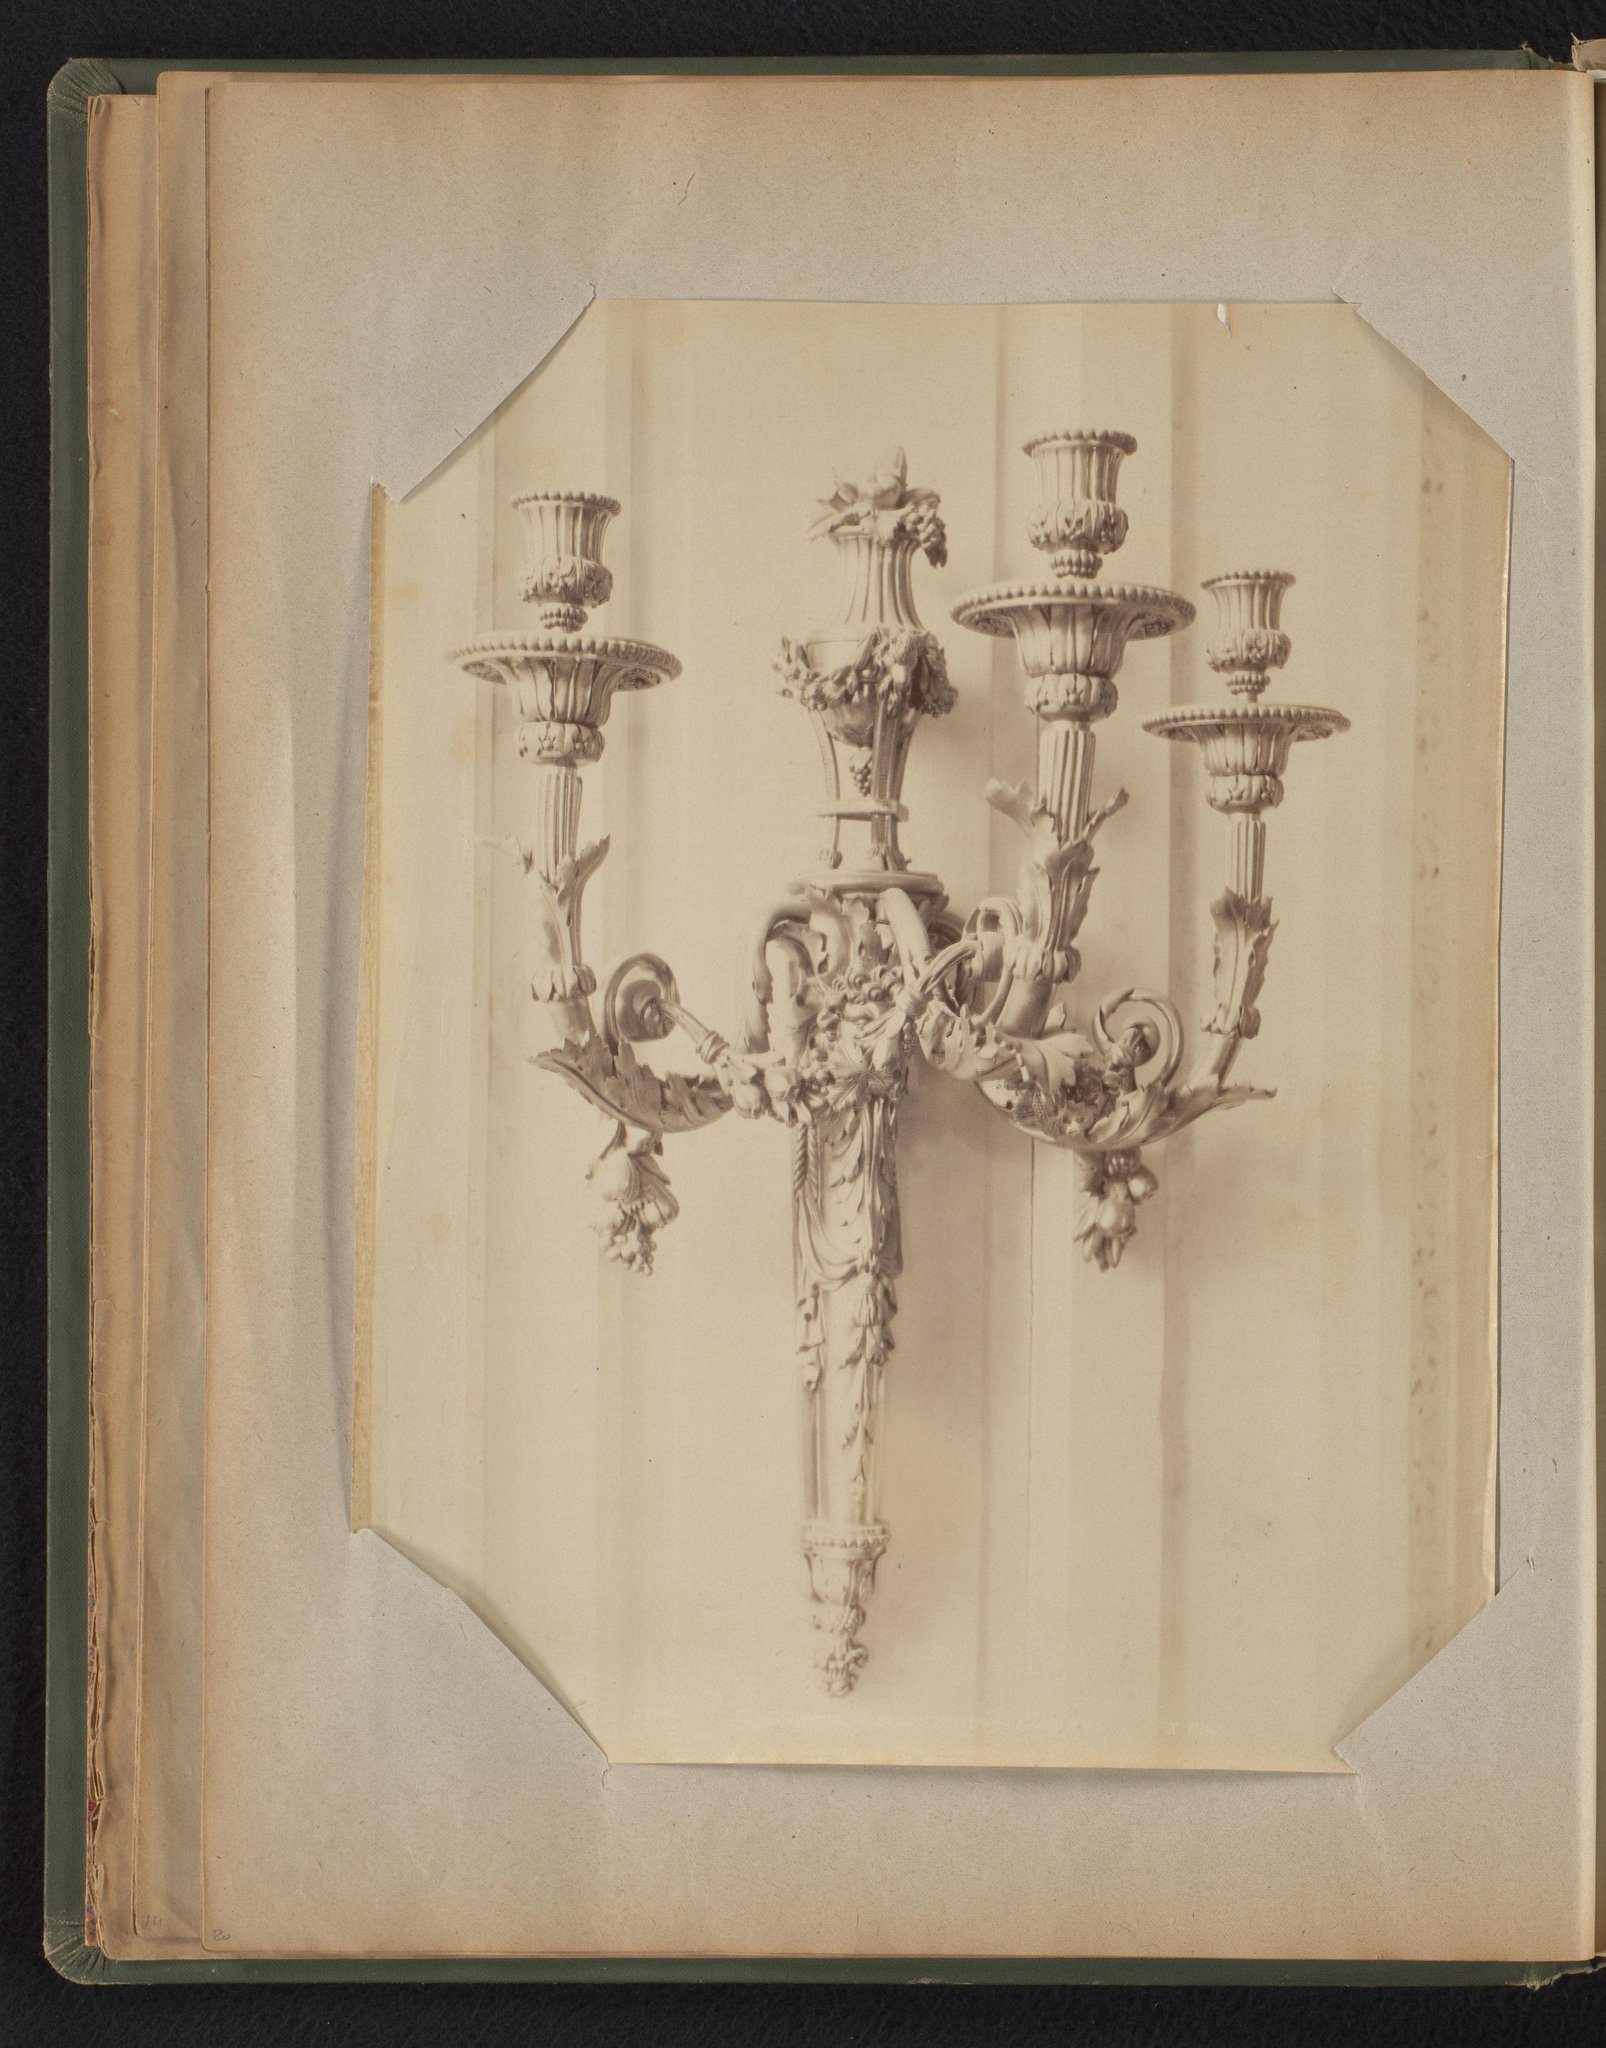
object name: photograph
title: Bronzen drie armige wandkandelaar voorzien van ornamenten en versieringen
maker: Anonymous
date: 1860-1900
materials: canvas, cardboard, paper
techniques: albumen print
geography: netherlands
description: Onderdeel van een serie met betrekking tot het interieur van het paleis van Versailles met kroonluchters, deuren, portalen en meubelstukken.